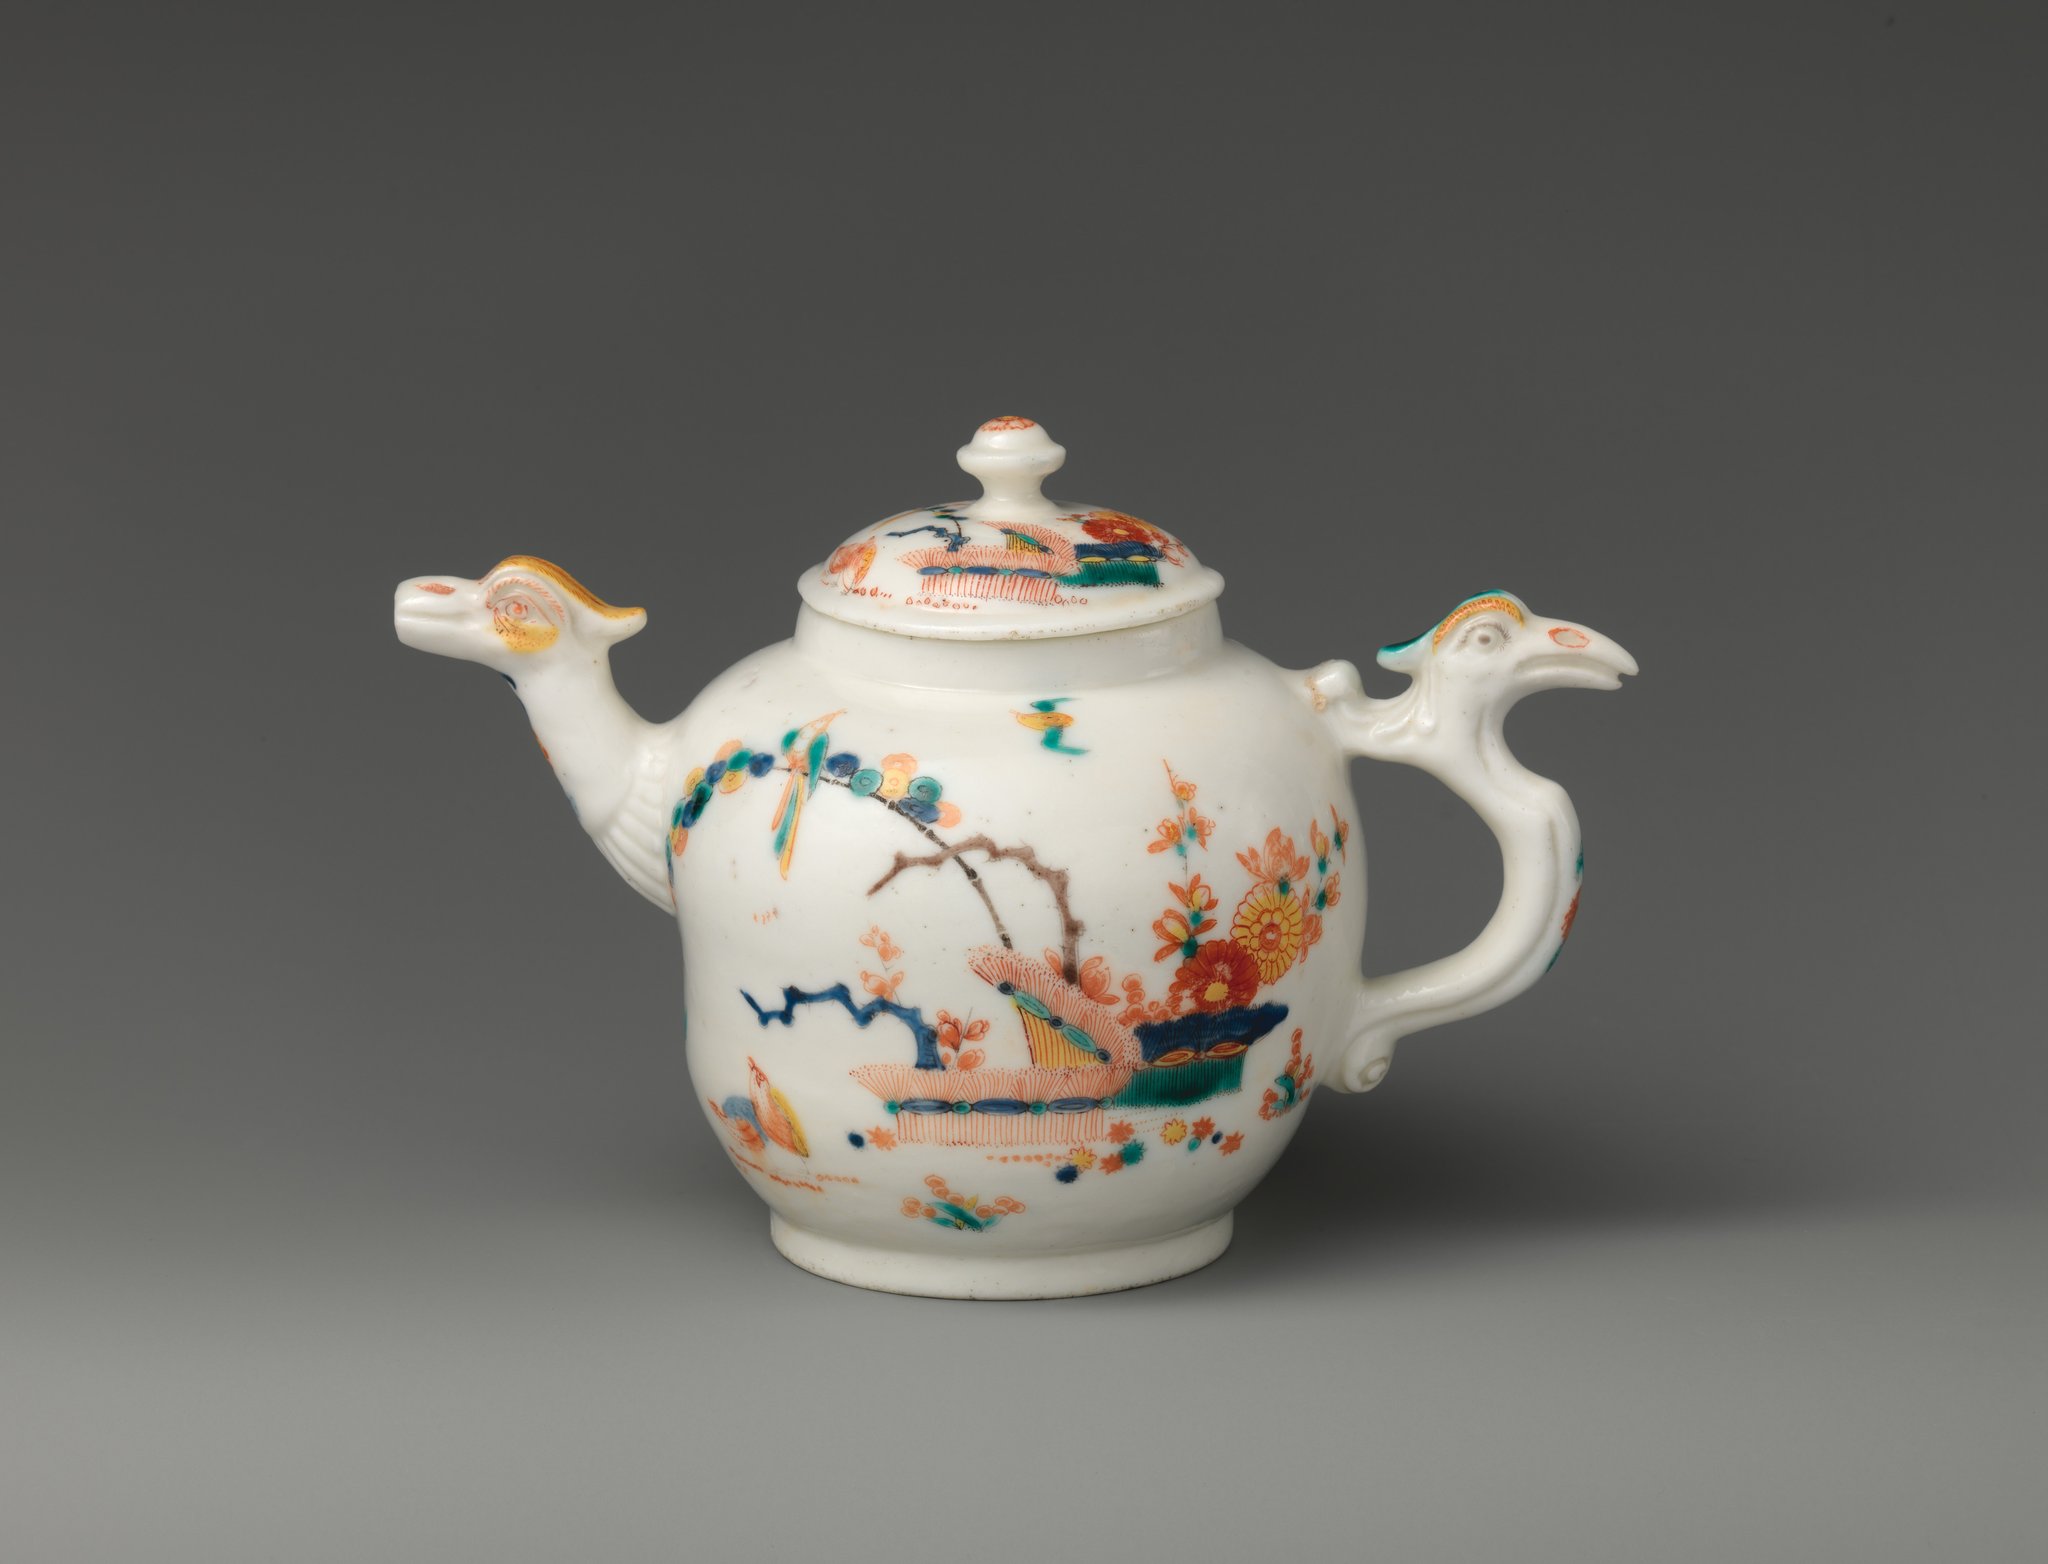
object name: teapot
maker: saint-cloud factory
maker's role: manufactory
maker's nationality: french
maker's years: 1693-1766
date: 1720-1730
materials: soft paste porcelain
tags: birds